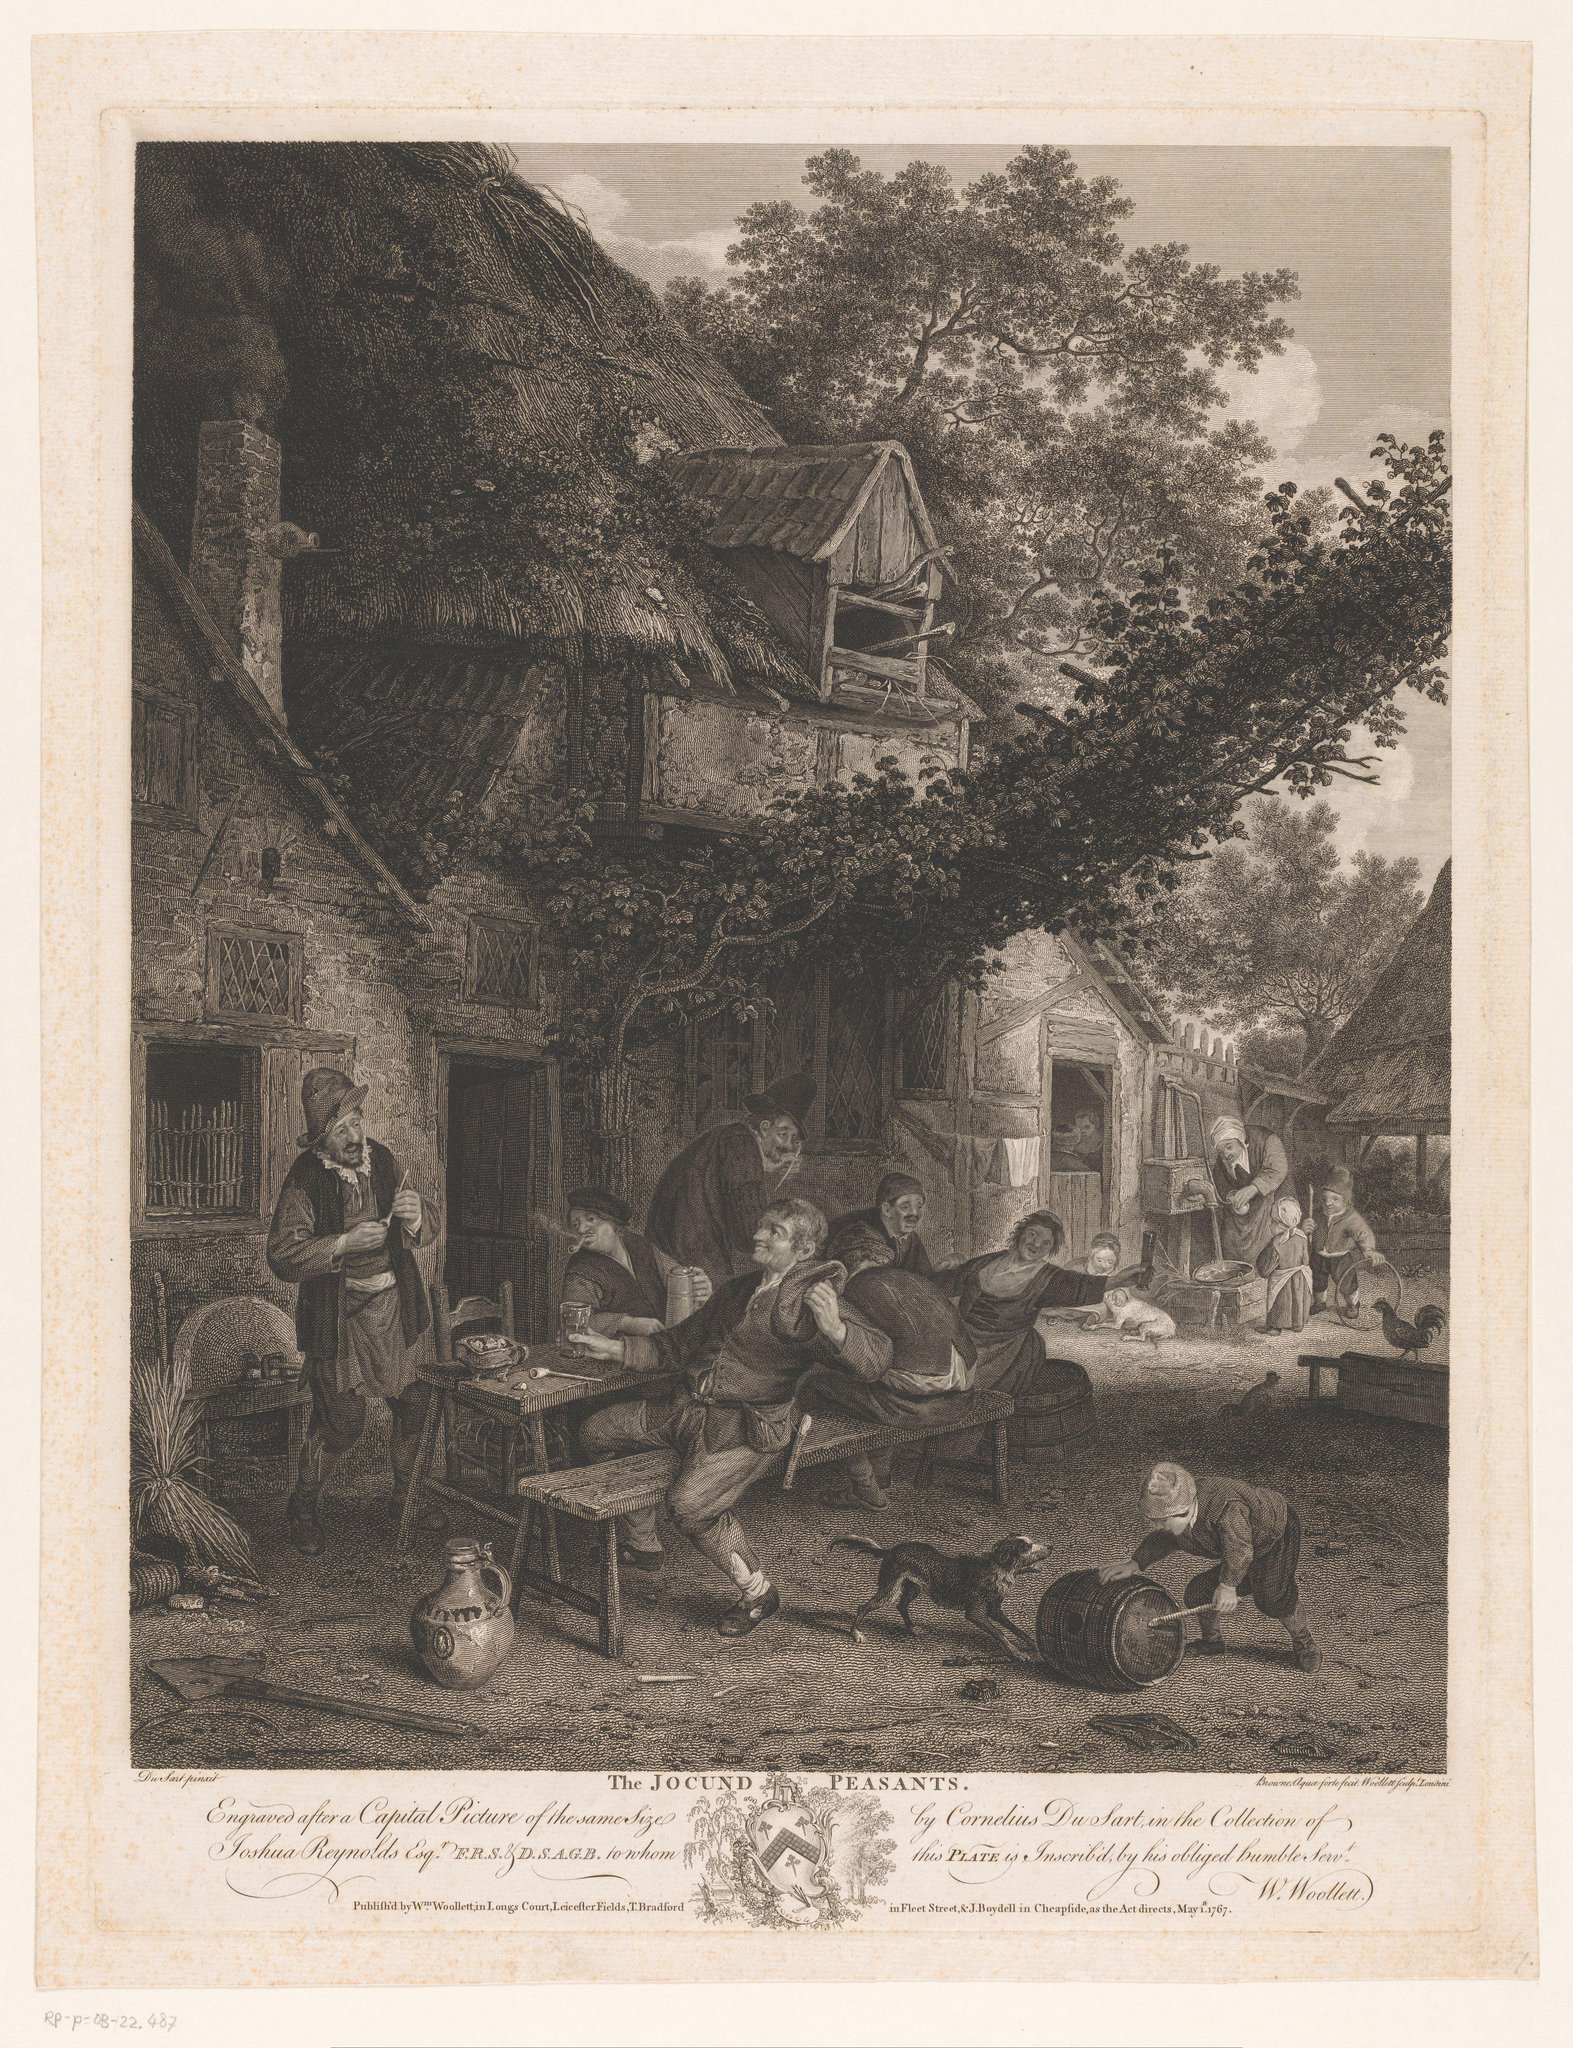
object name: print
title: The Jocund Peasants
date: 1767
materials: paper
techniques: engraving, etching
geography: london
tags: hotel, hostelry, inn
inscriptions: collector's mark: Lugt 240